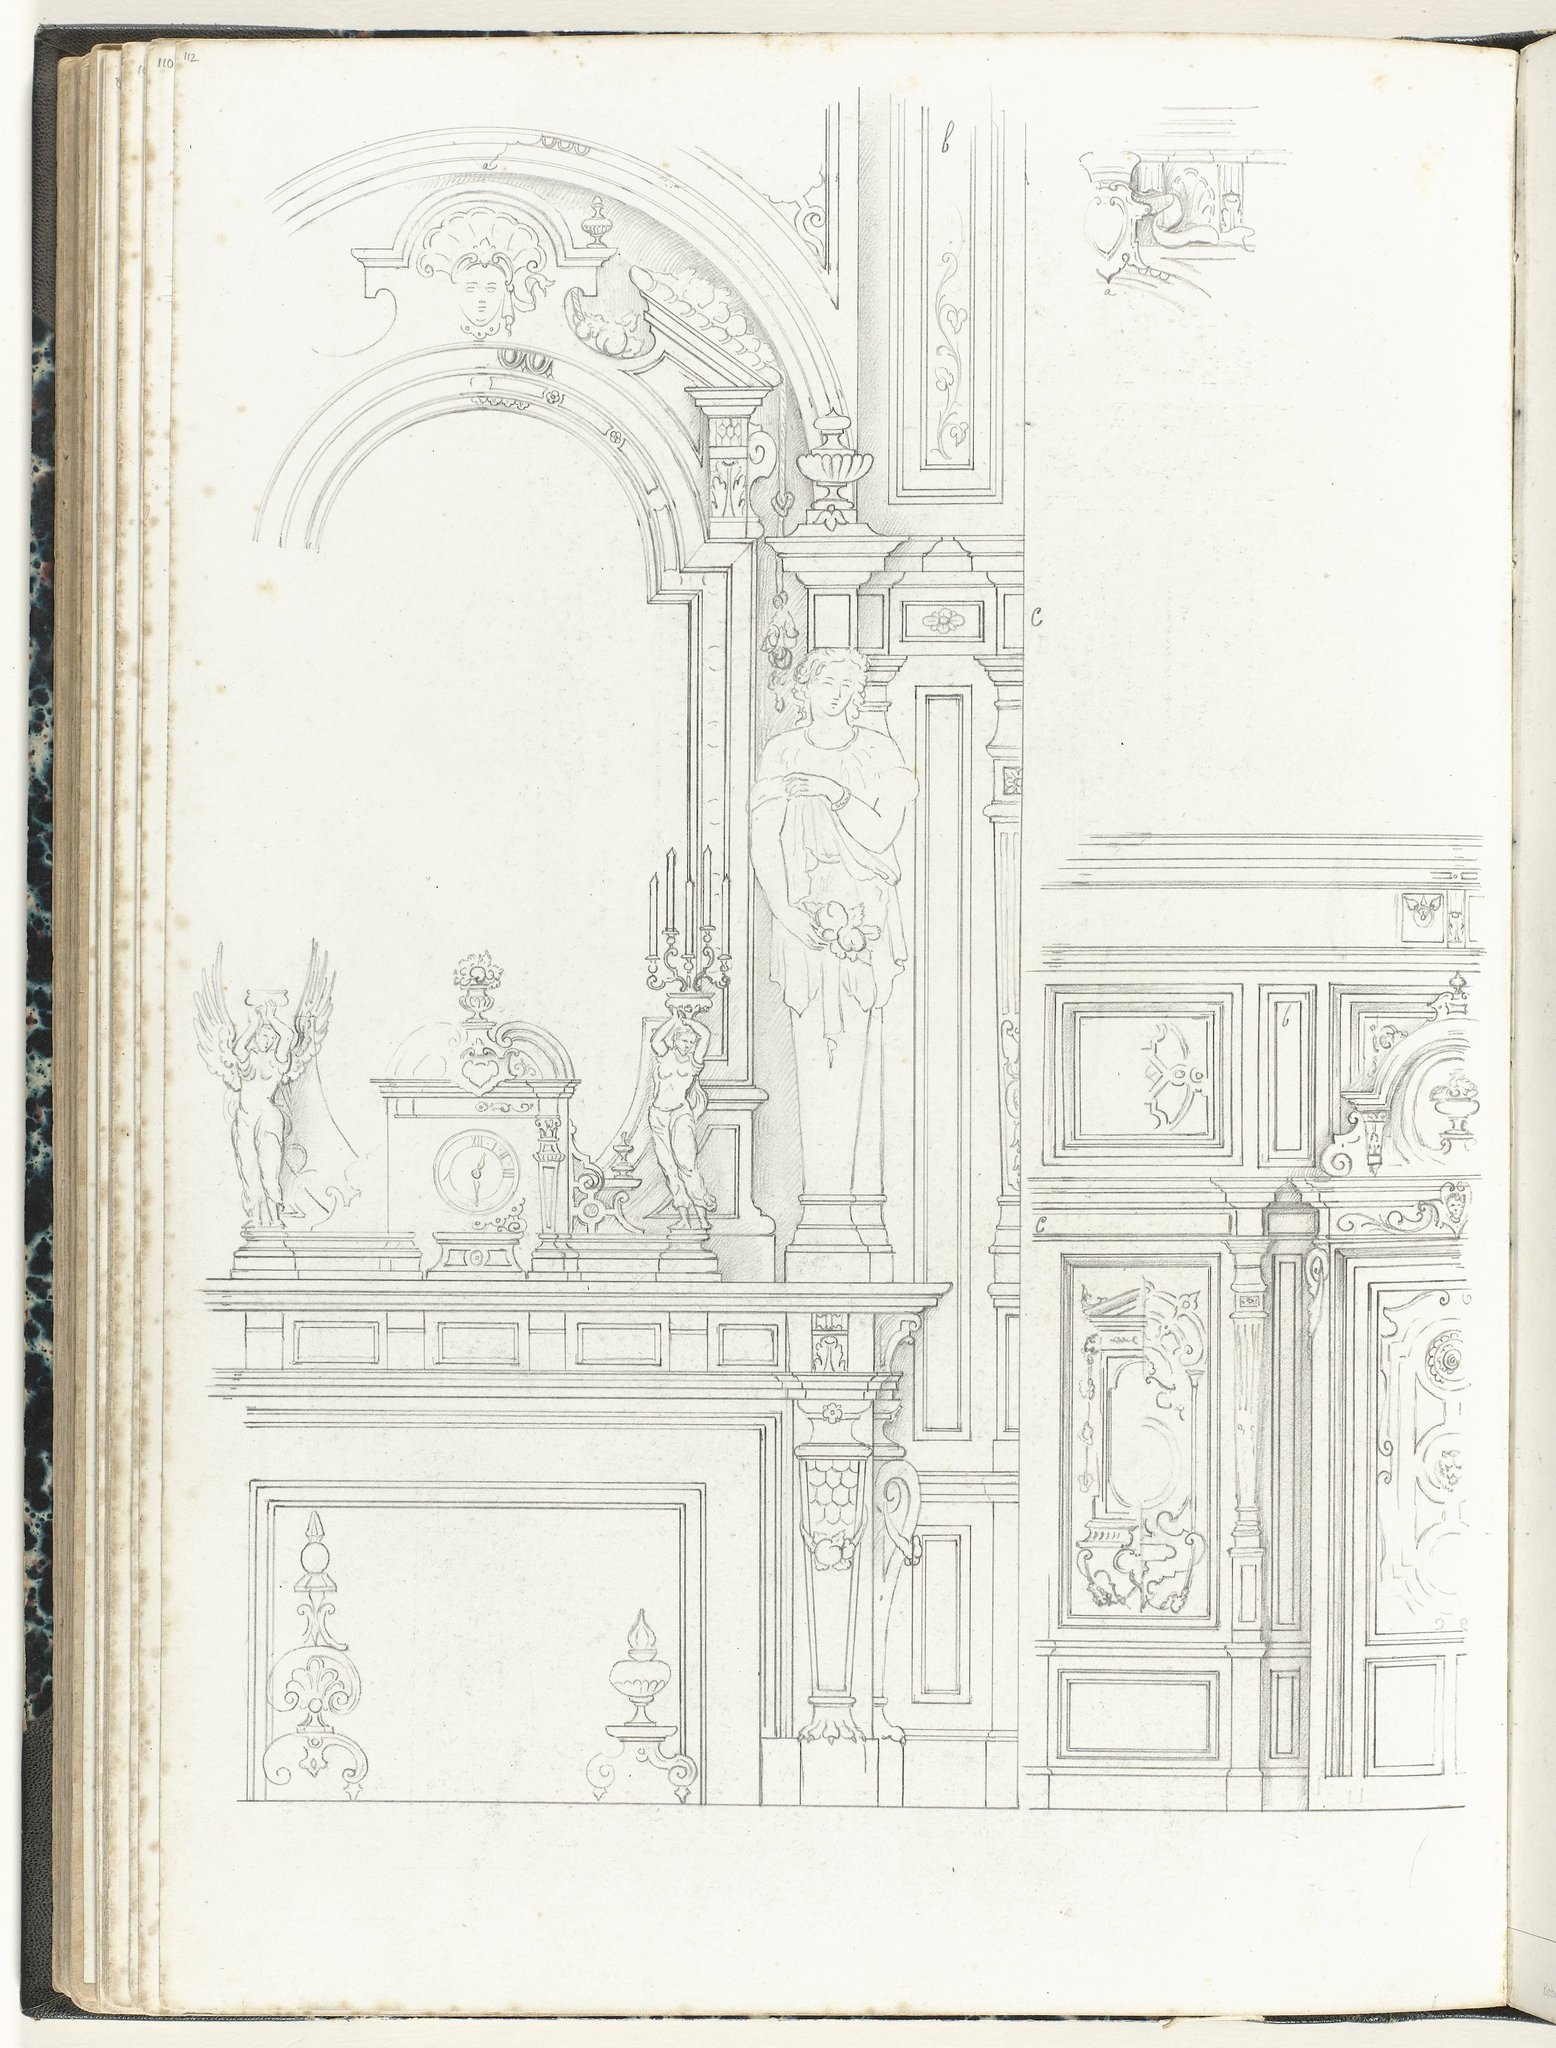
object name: drawing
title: Onderboezem, muur en klein ornament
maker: Anonymous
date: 1866-1900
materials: paper, pencil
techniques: drawing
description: Op de schoorsteenplaat staat een klok tussen twee kandelaars in de vorm van vrouwelijke figuren, de een met vleugels, de ander zonder. Rechts van de onderboezem is een muur te zien met houten lambrisering, rechtsboven een klein ornament met een schild.